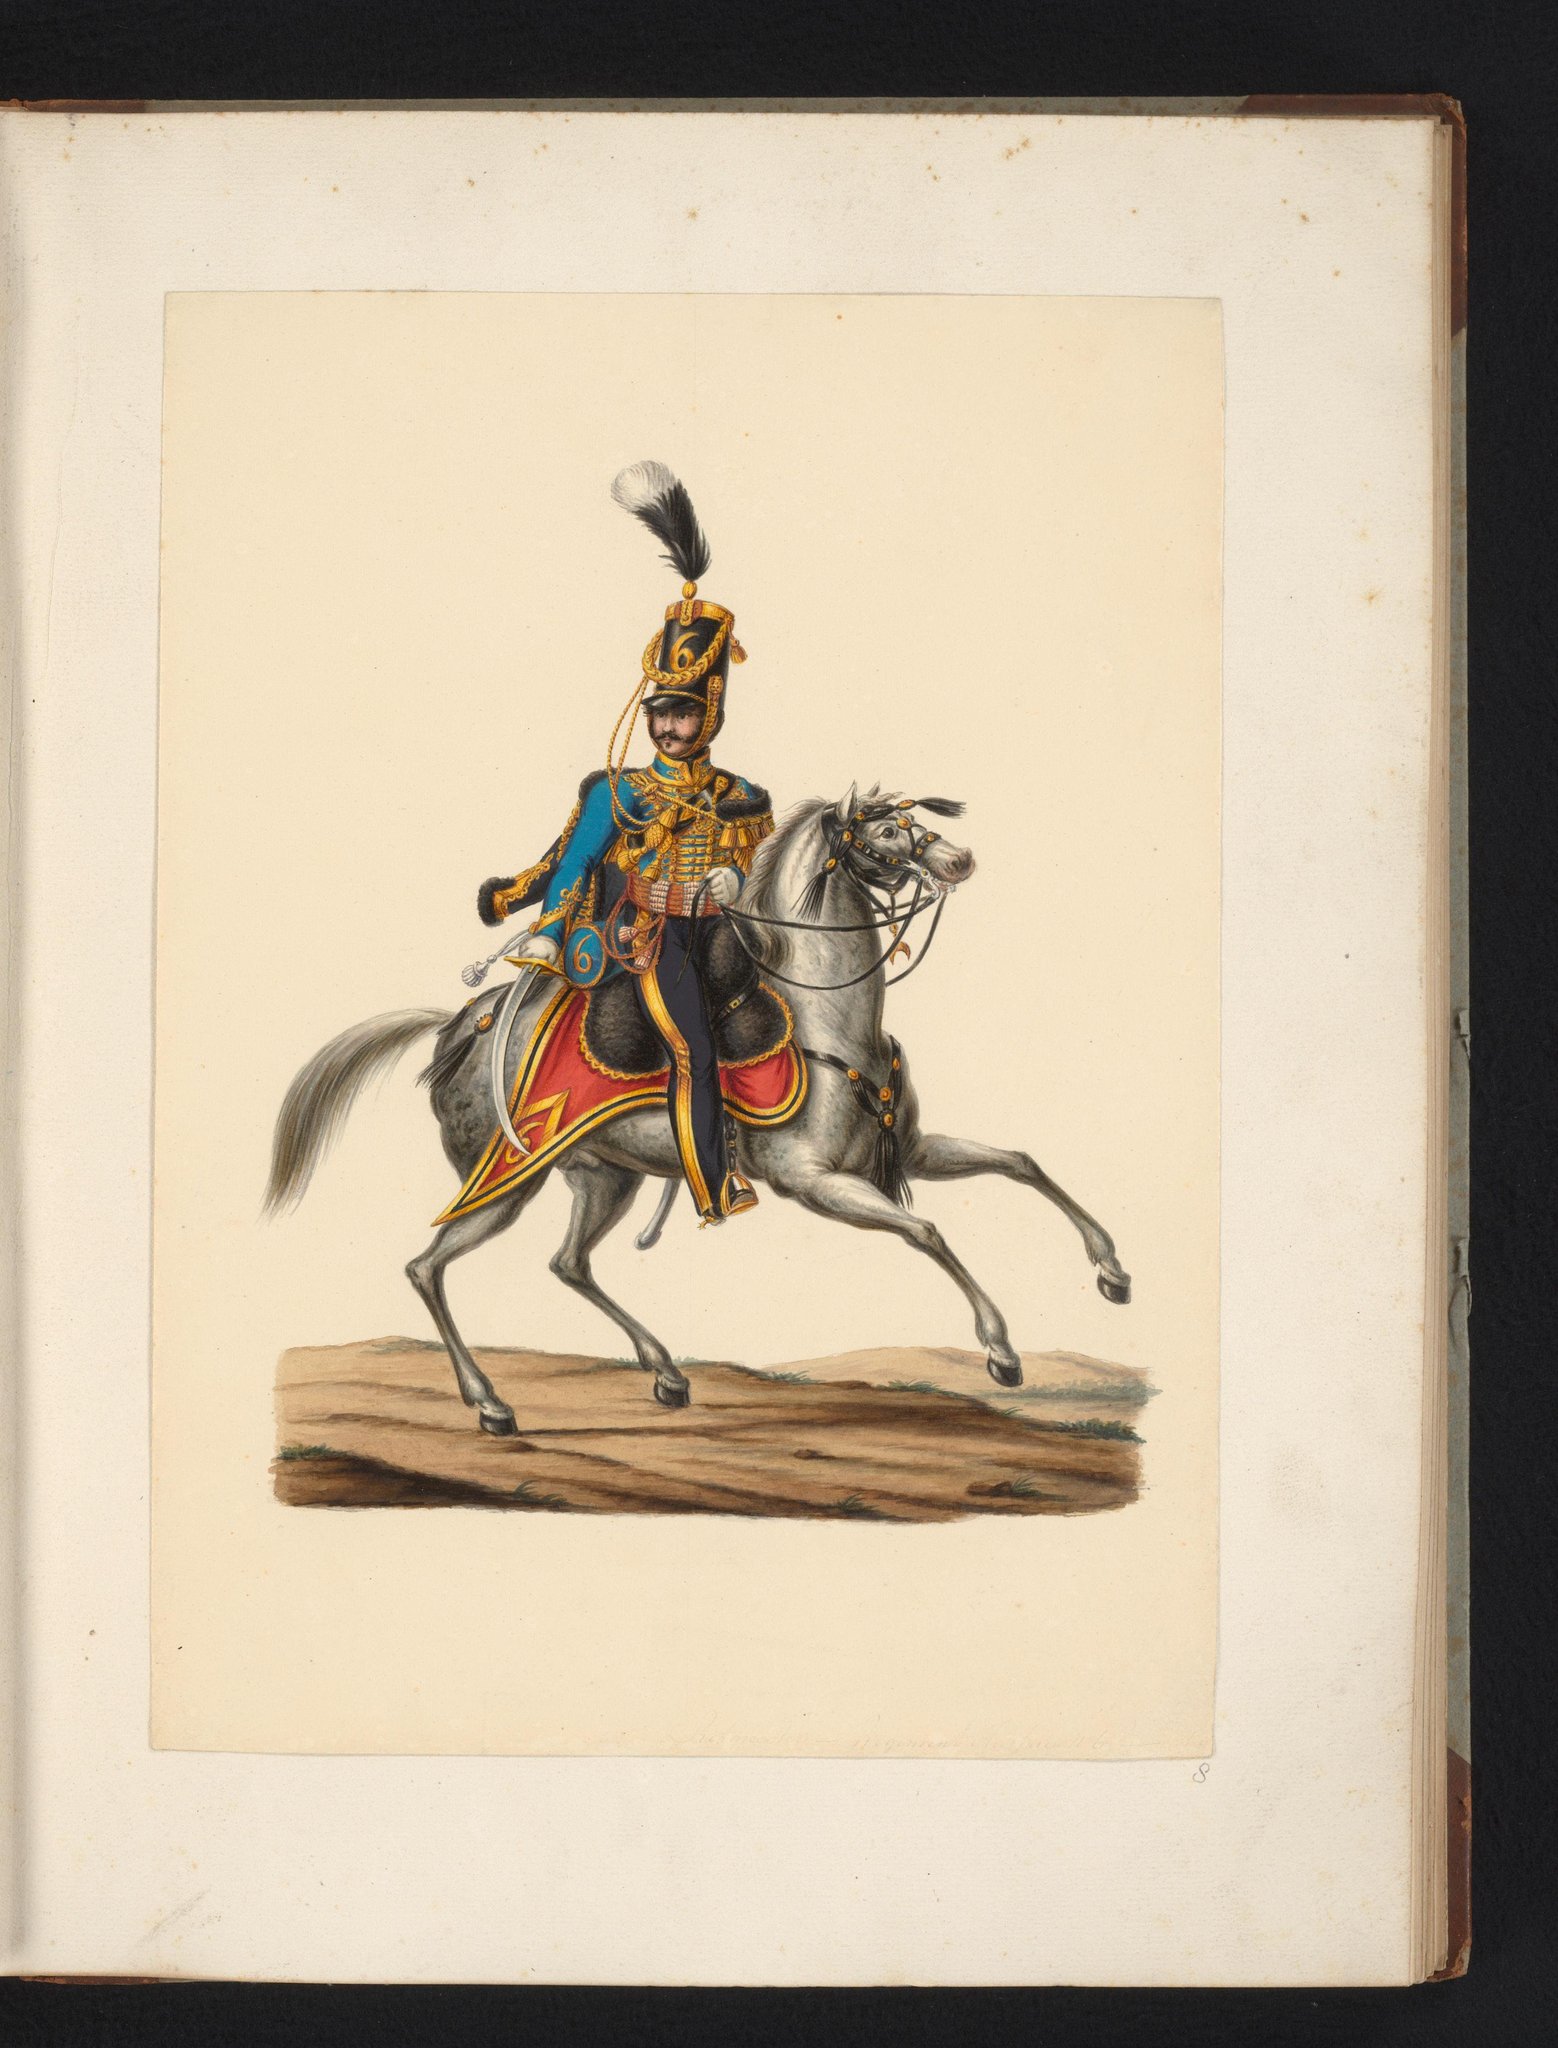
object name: drawing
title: Ritmeester van de huzaren, 1830-1831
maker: Anonymous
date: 1831-1832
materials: paper, pencil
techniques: brush, lacquer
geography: netherlands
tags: professional clothes, (military) uniforms, netherlands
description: Een ritmeester van het Regiment Huzaren nr 6, te paard. Onderdeel van het album met 39 ingeplakte tekeningen van militairen van de Koninklijke Nederlandsche Armee uit 1830-1831.